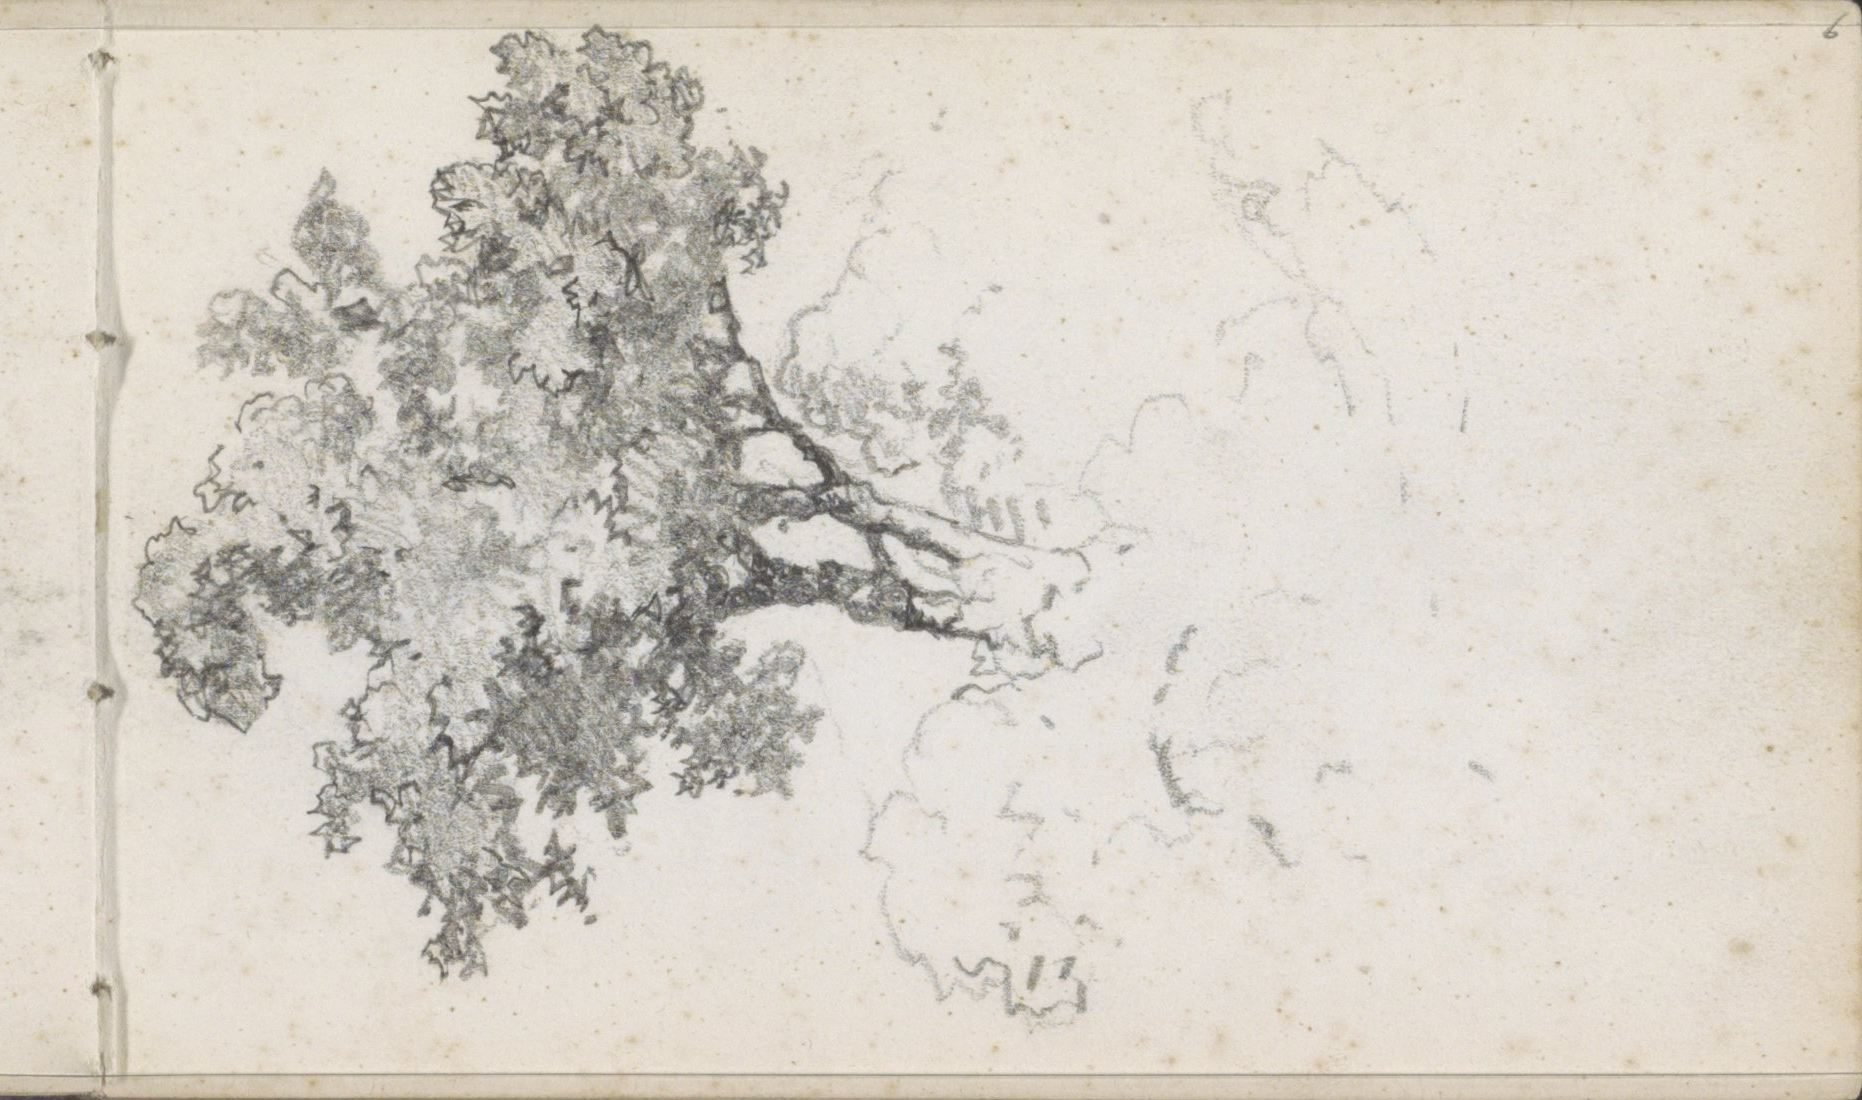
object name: sketchbook leaf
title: Boom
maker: maria vos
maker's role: draughtsman, painter, print maker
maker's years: 1824-1906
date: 1863-1864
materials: paper, pencil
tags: trees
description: Blad 6 recto uit een schetsboek met 41 bladen.